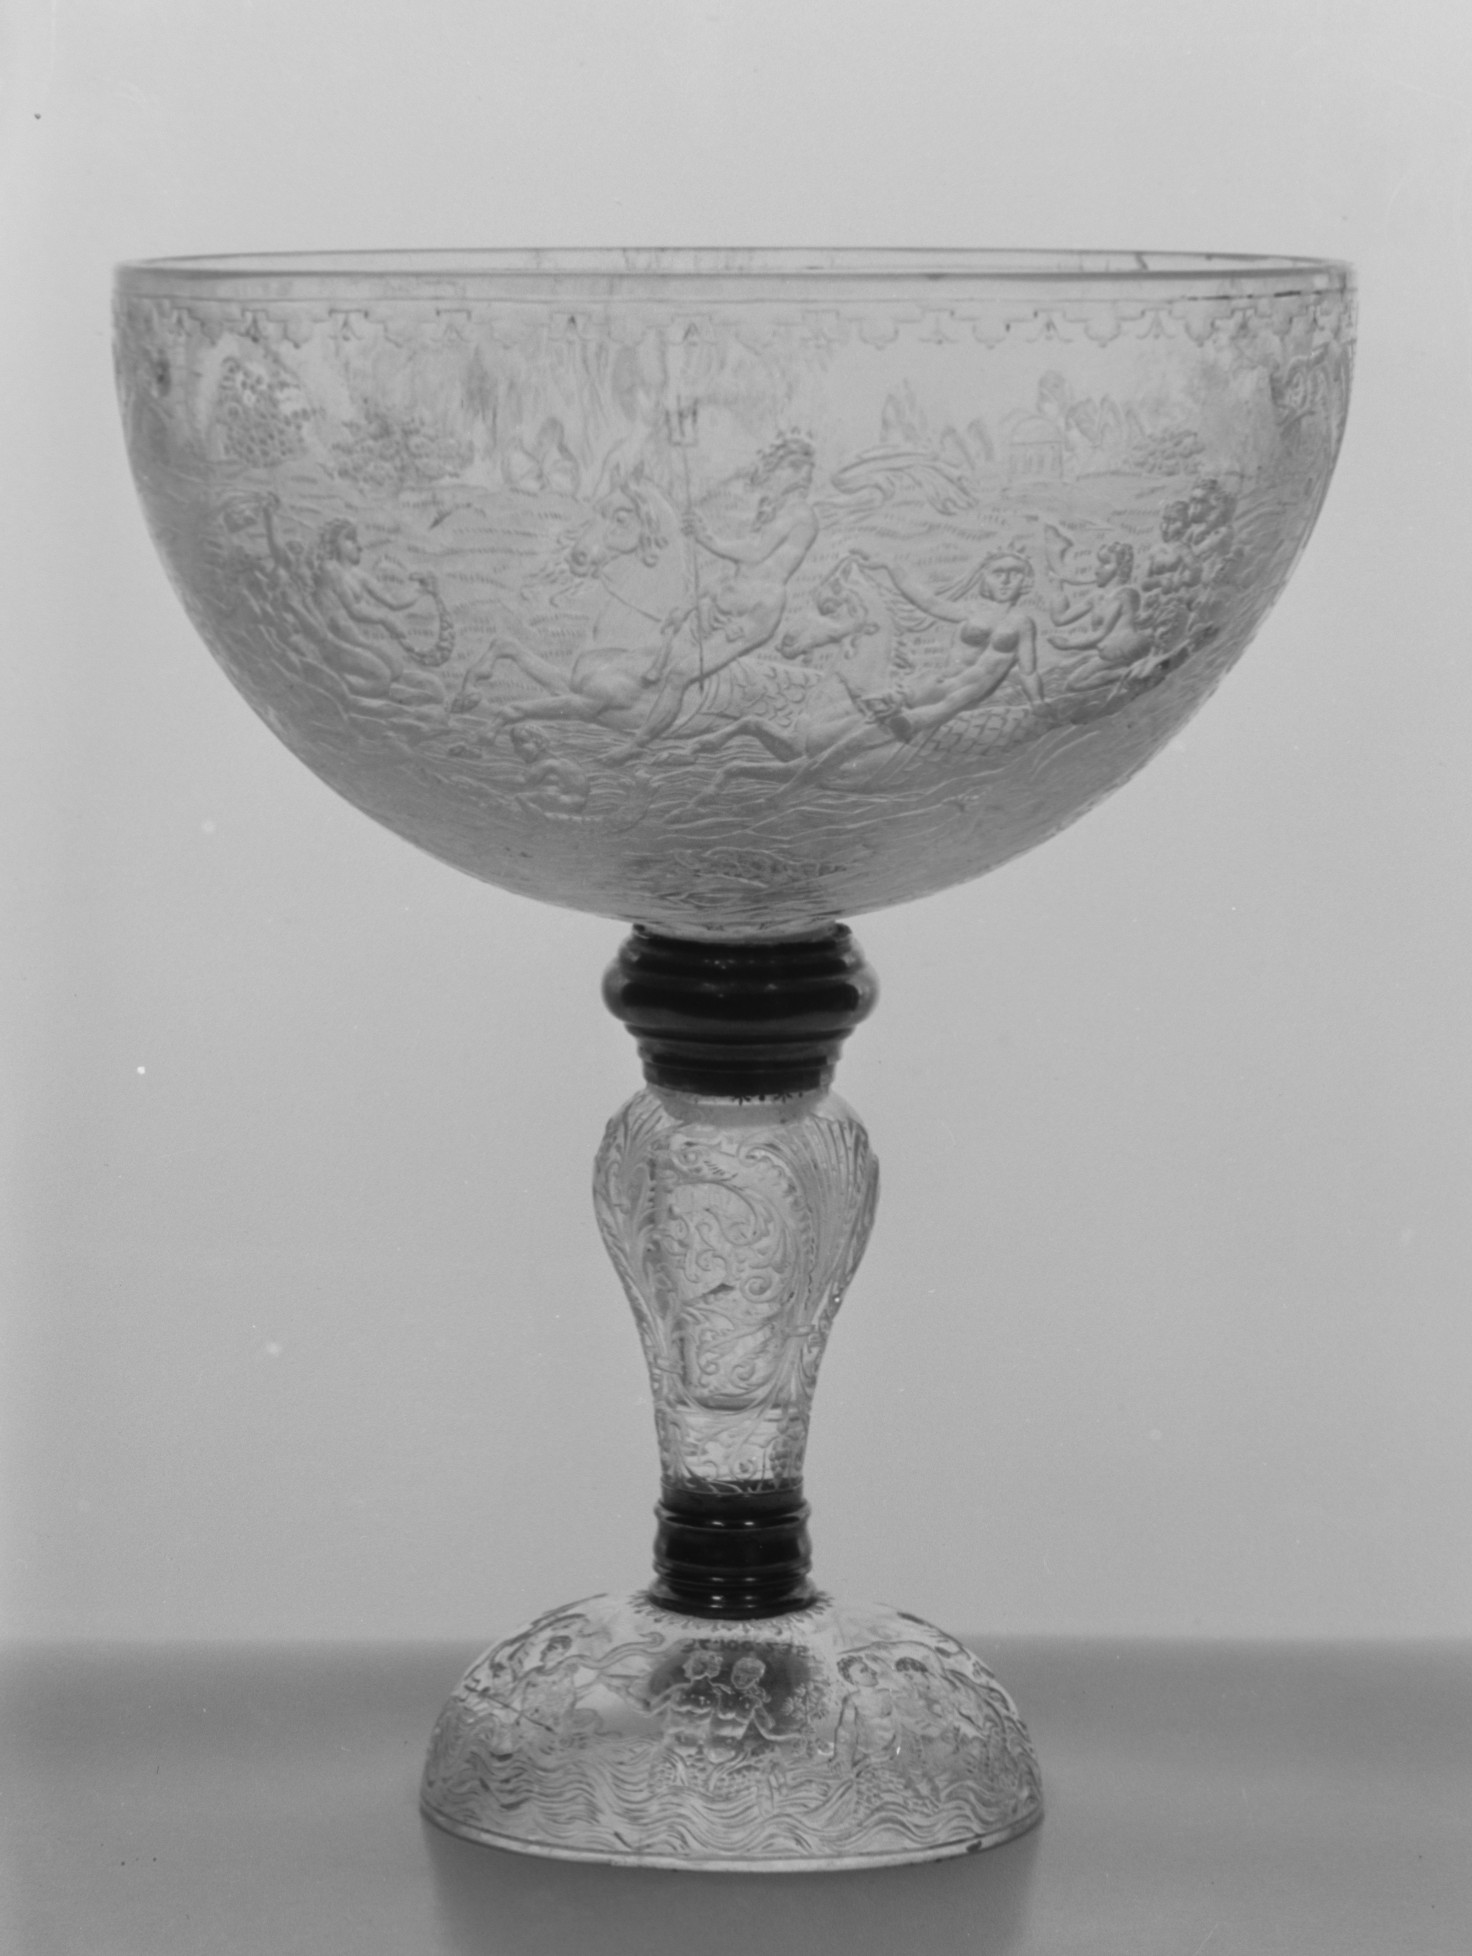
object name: standing cup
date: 1501-1550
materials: quartz, silver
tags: animals,men